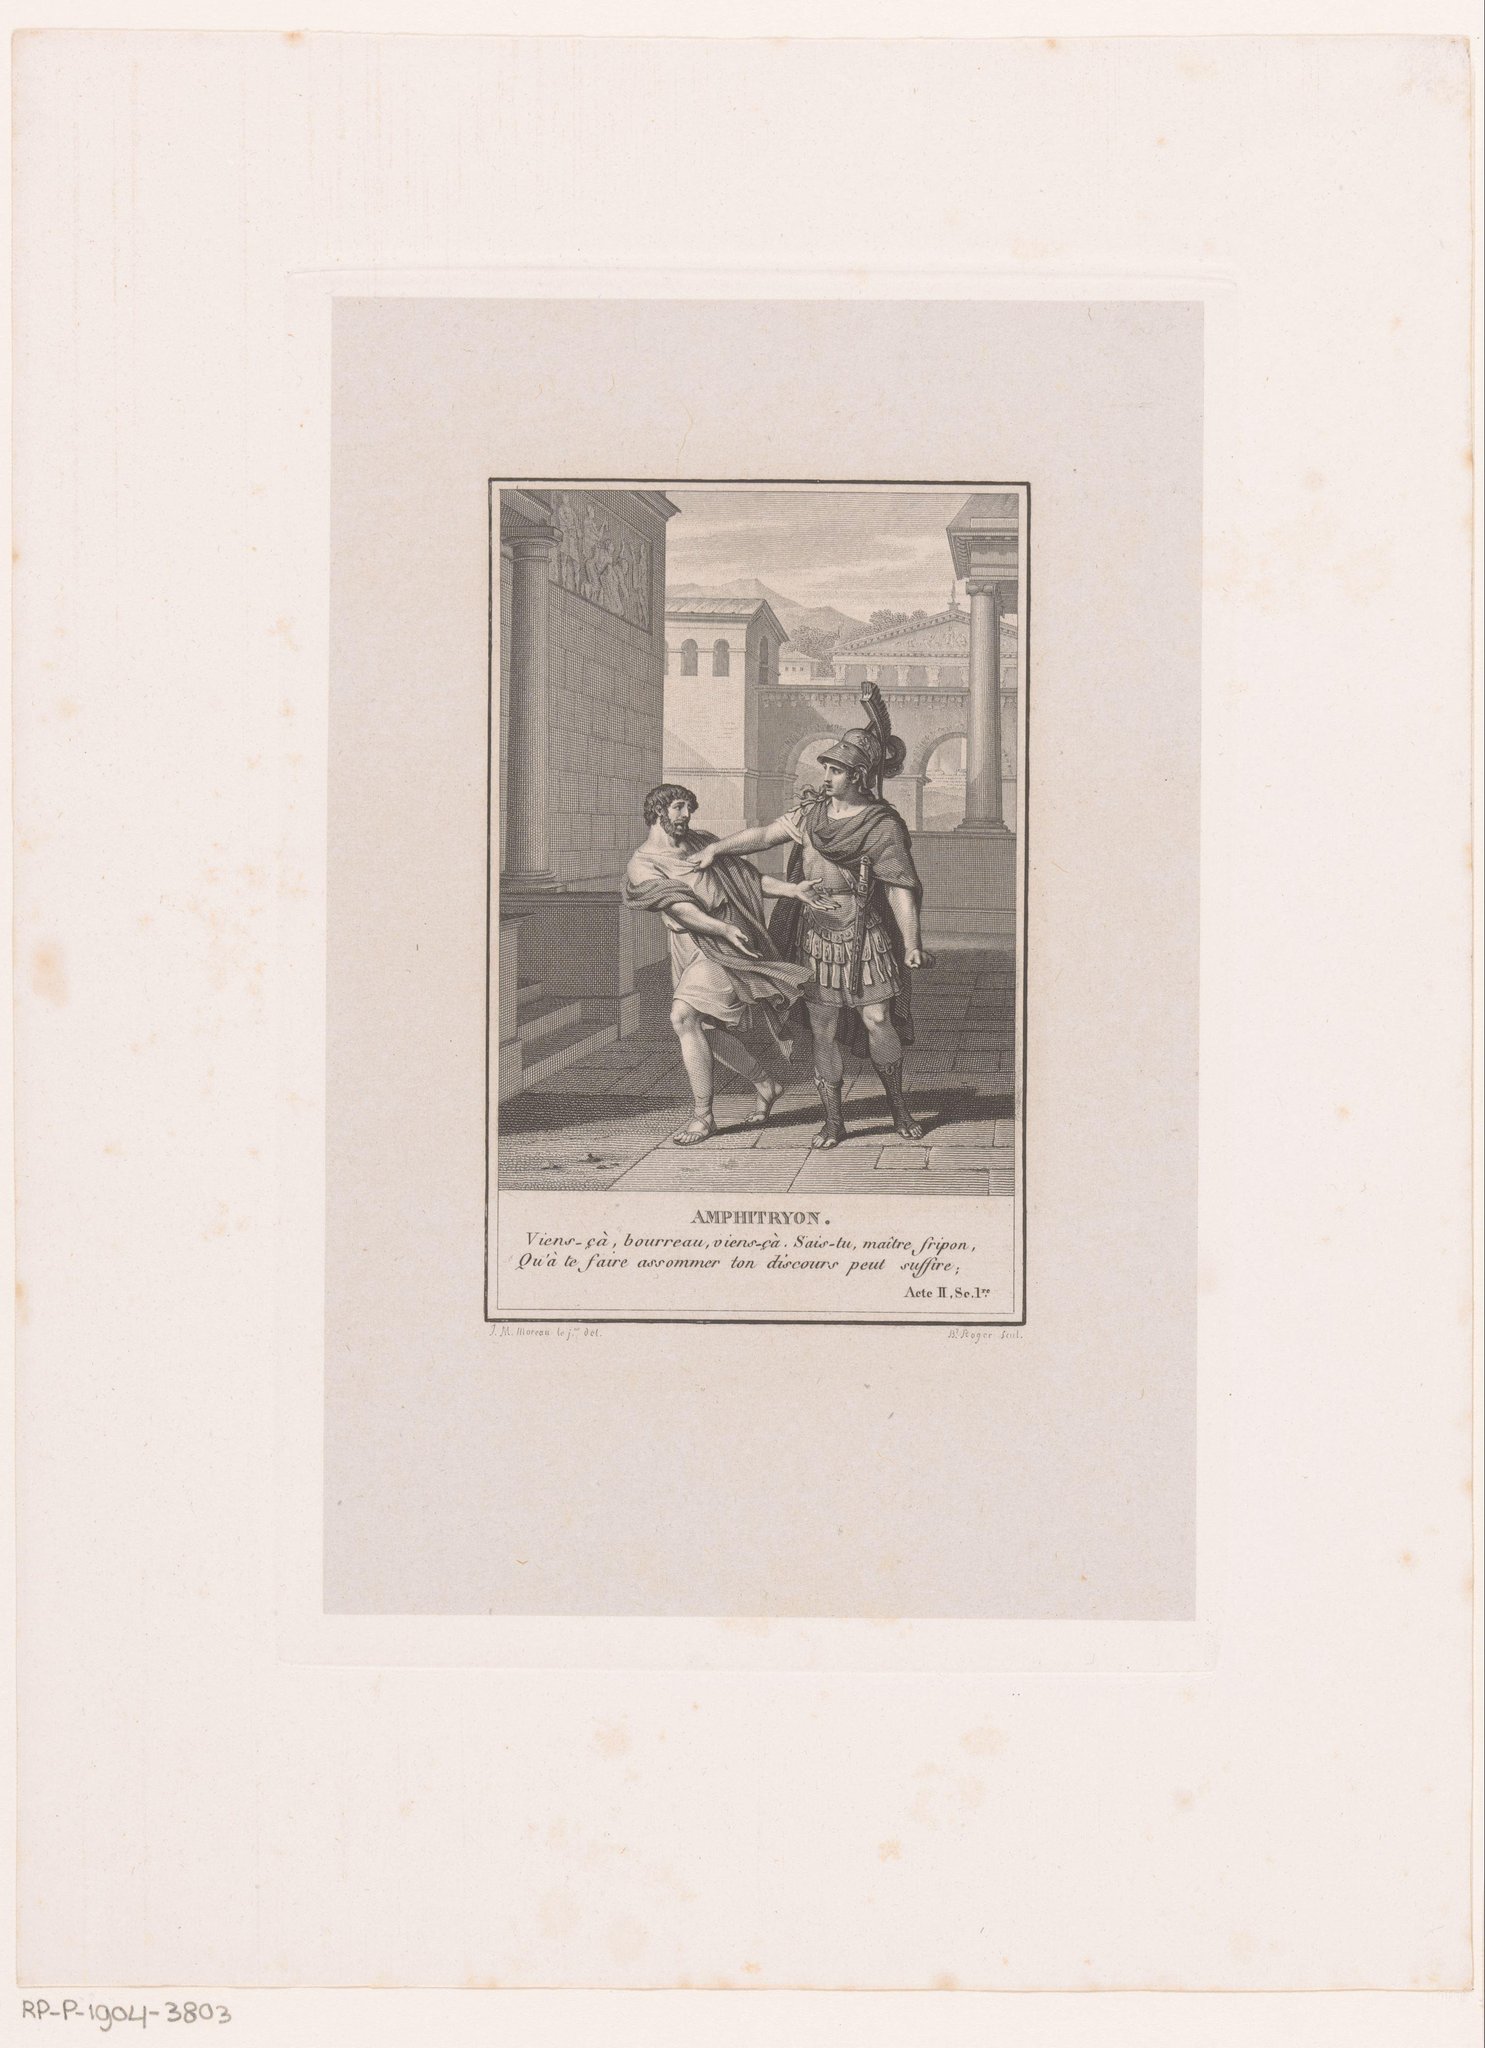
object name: print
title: Portret van Jacques Marie Louis van Rechteren met zijn vrouw en zoon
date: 1800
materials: paper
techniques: etching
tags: earl, parents with their children, historical persons, dog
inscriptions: collector's mark: Lugt 2228